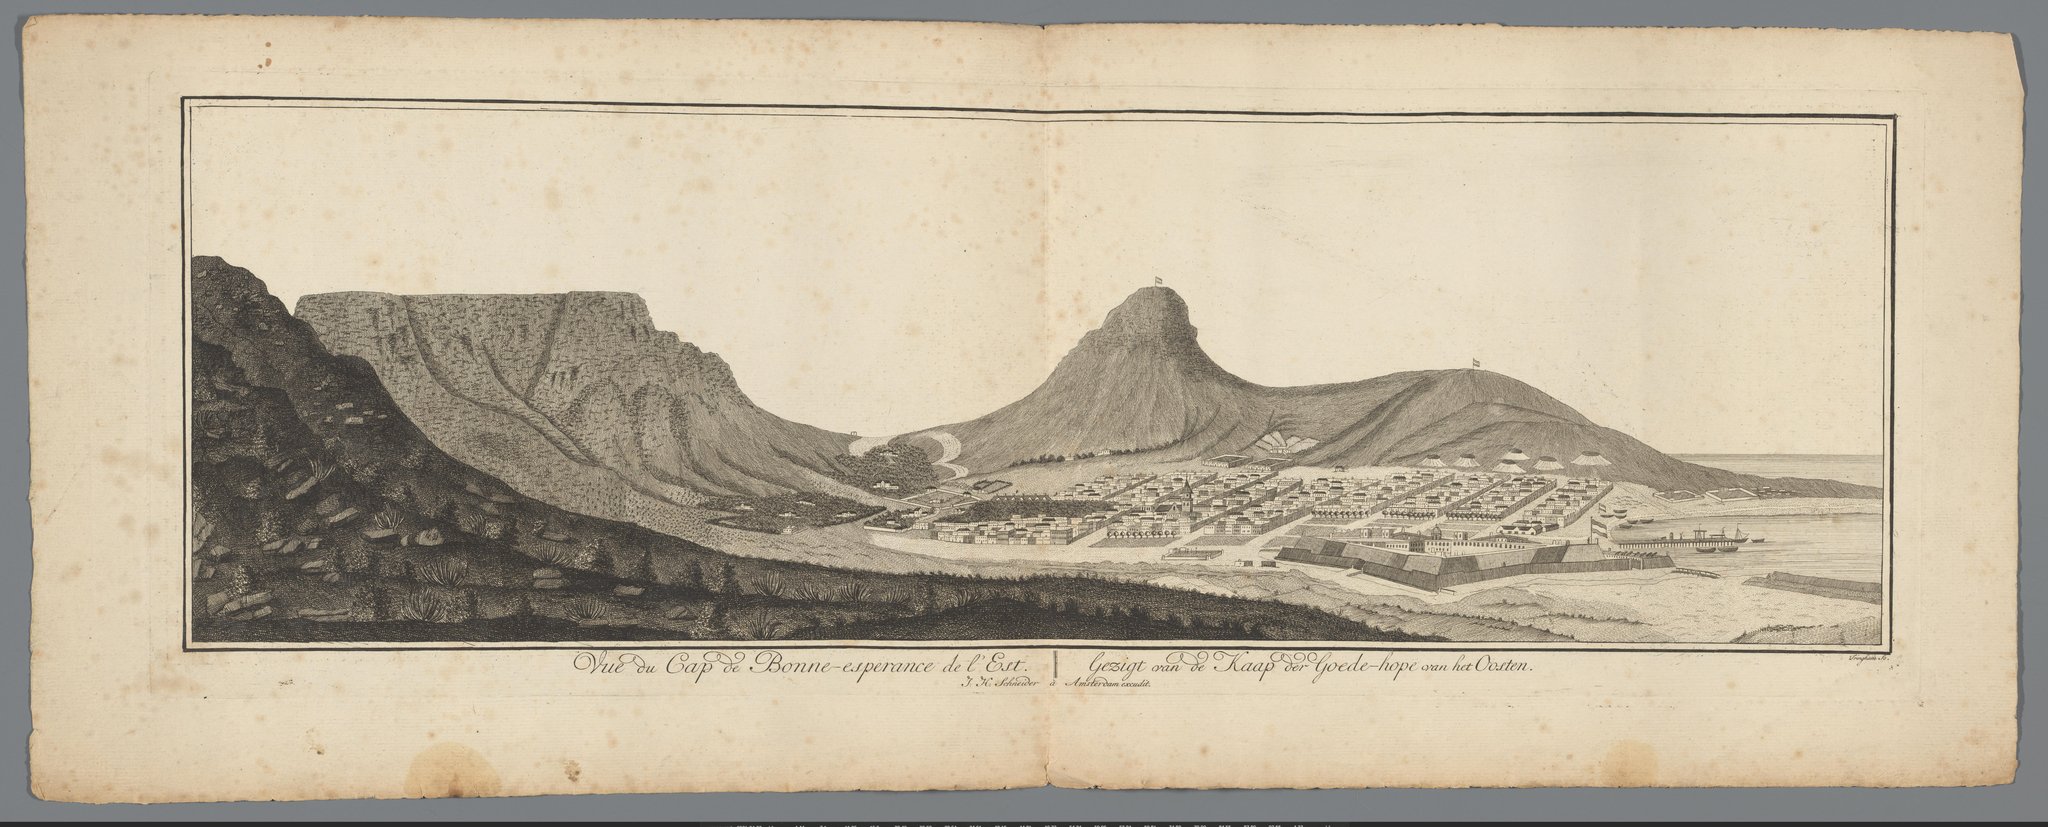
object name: print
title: Gezicht op Kaap de Goede Hoop vanuit het oosten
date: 1777-1785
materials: paper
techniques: etching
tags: prospect of city, town panorama, silhouette of city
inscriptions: label: ‘B10’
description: Gezicht op Kaap de Goede Hoop, gezien vanuit het oosten. Centraal Kaapstad met de Leeuwenkop, links de Tafelberg. Naar het linker- en middenblad van de grote panorama van Schumacher.